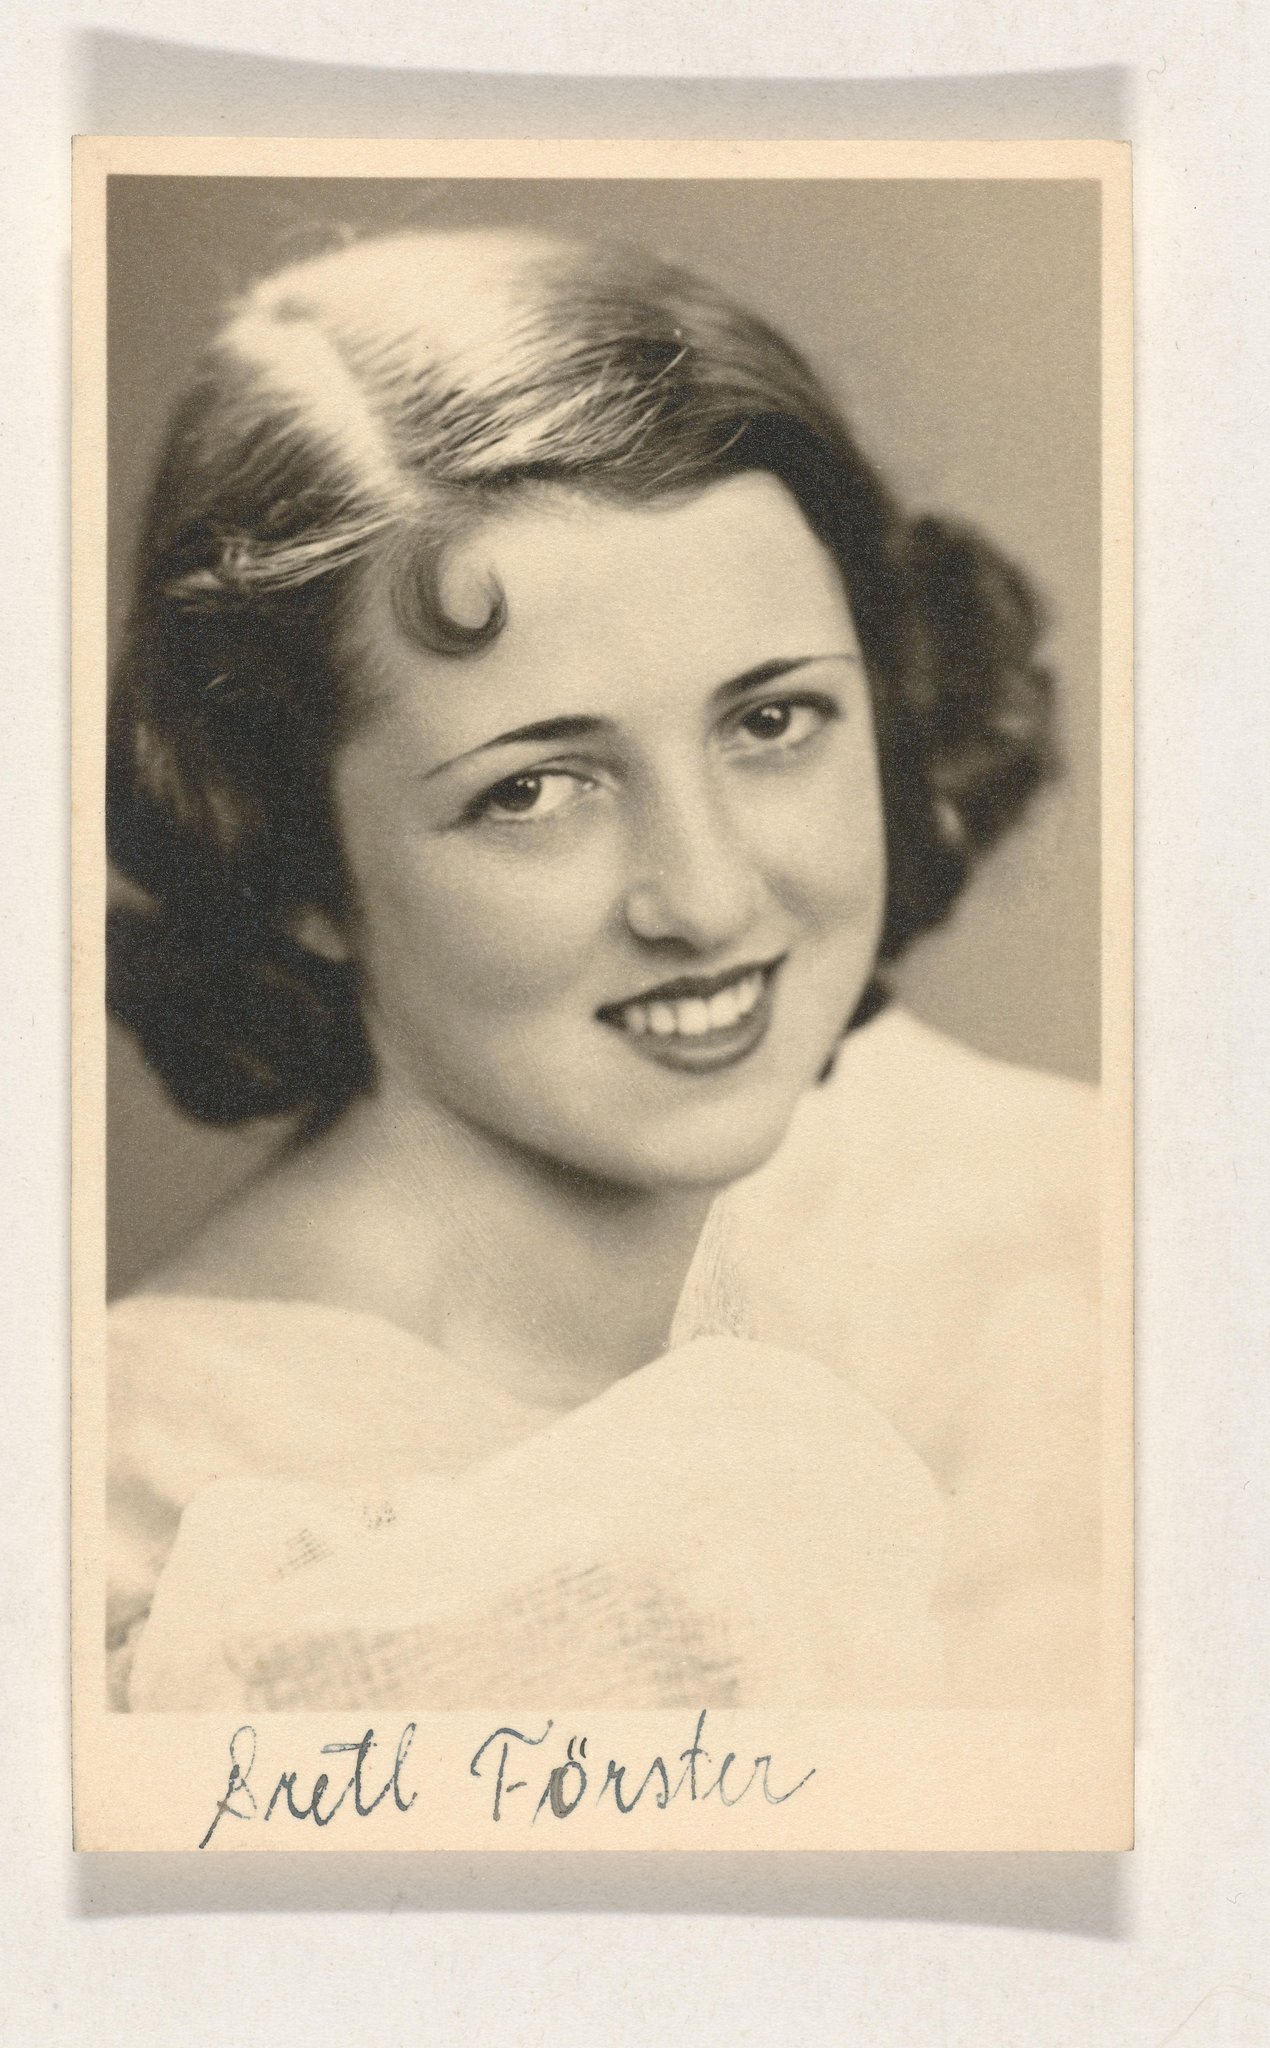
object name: photograph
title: Portret van de jonge vrouw Brett Forster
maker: hedda medina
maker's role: danseres, fotograaf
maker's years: 1911-1951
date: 1928-1938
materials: photographic support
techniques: gelatin silver print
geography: vienna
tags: vienna